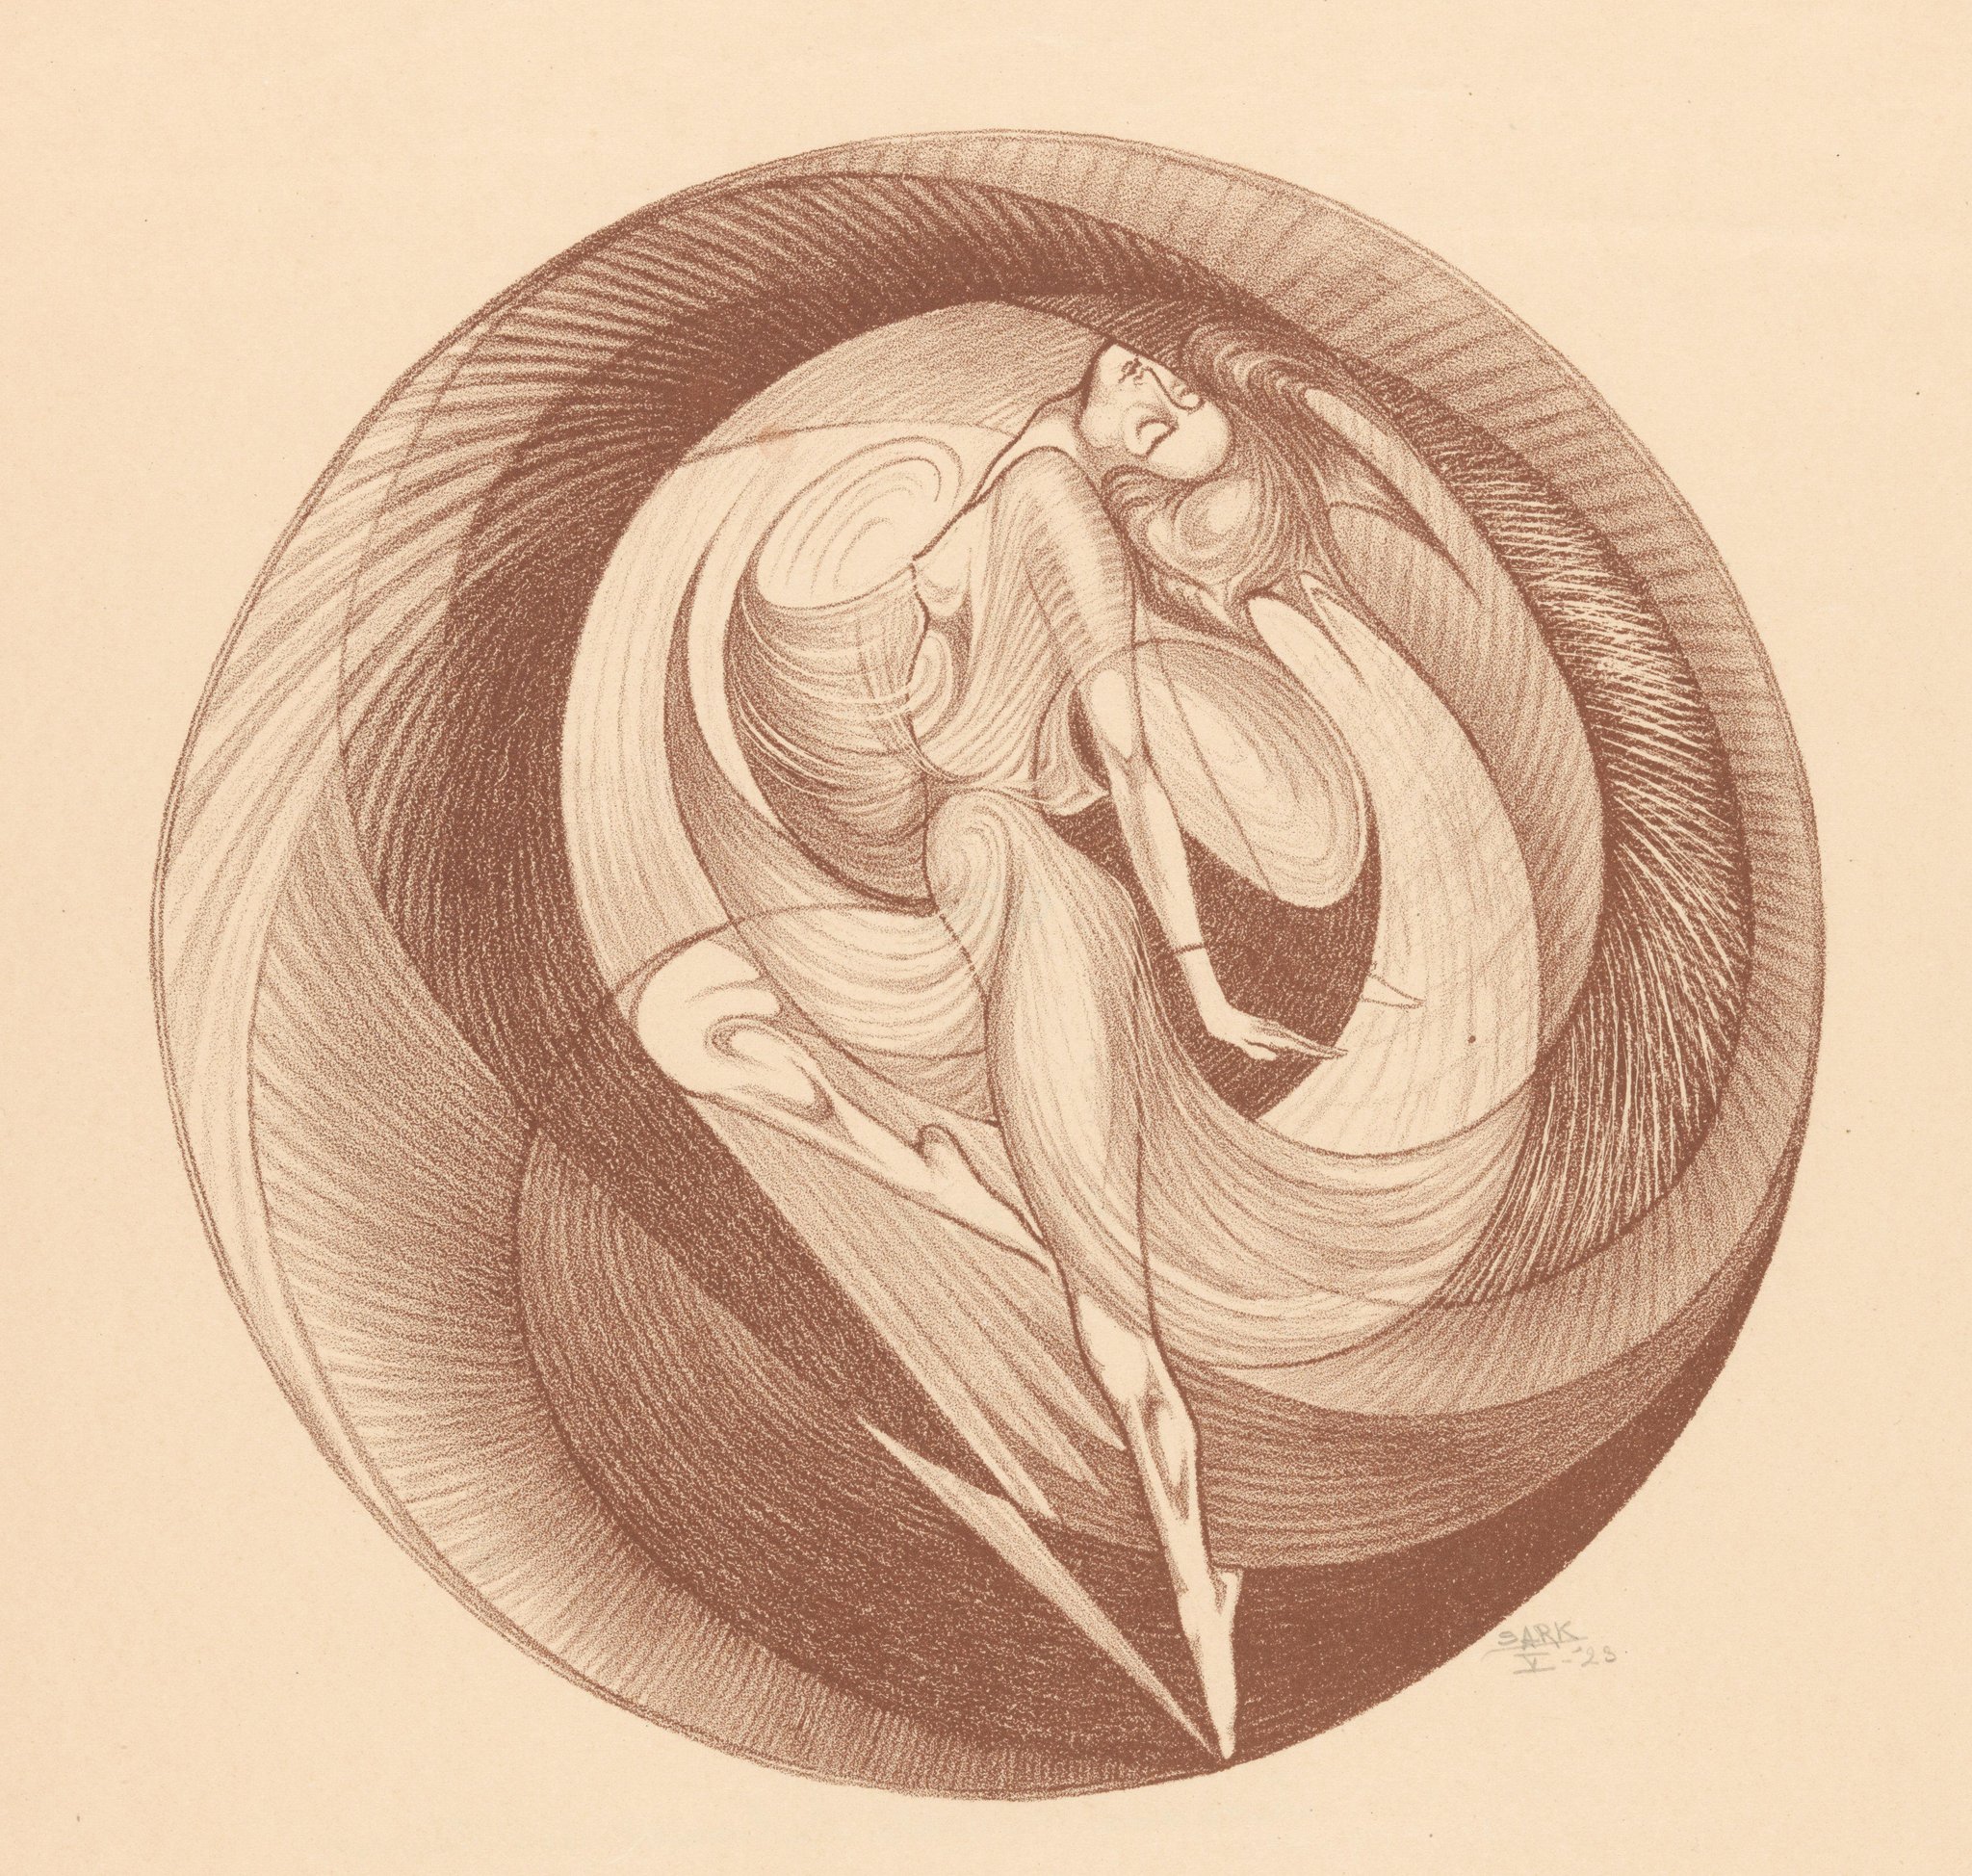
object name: print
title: Vrouwenfiguur in een cirkel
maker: suzanna anthonia rijkmans-kaijser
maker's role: print maker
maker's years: 1900-1954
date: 1905-1923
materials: paper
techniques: lithograph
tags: standing figure - aa - female human figure, circle (~ planimetry, geometry)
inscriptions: collector's mark: Lugt 2228, collector's mark: Lugt 2760